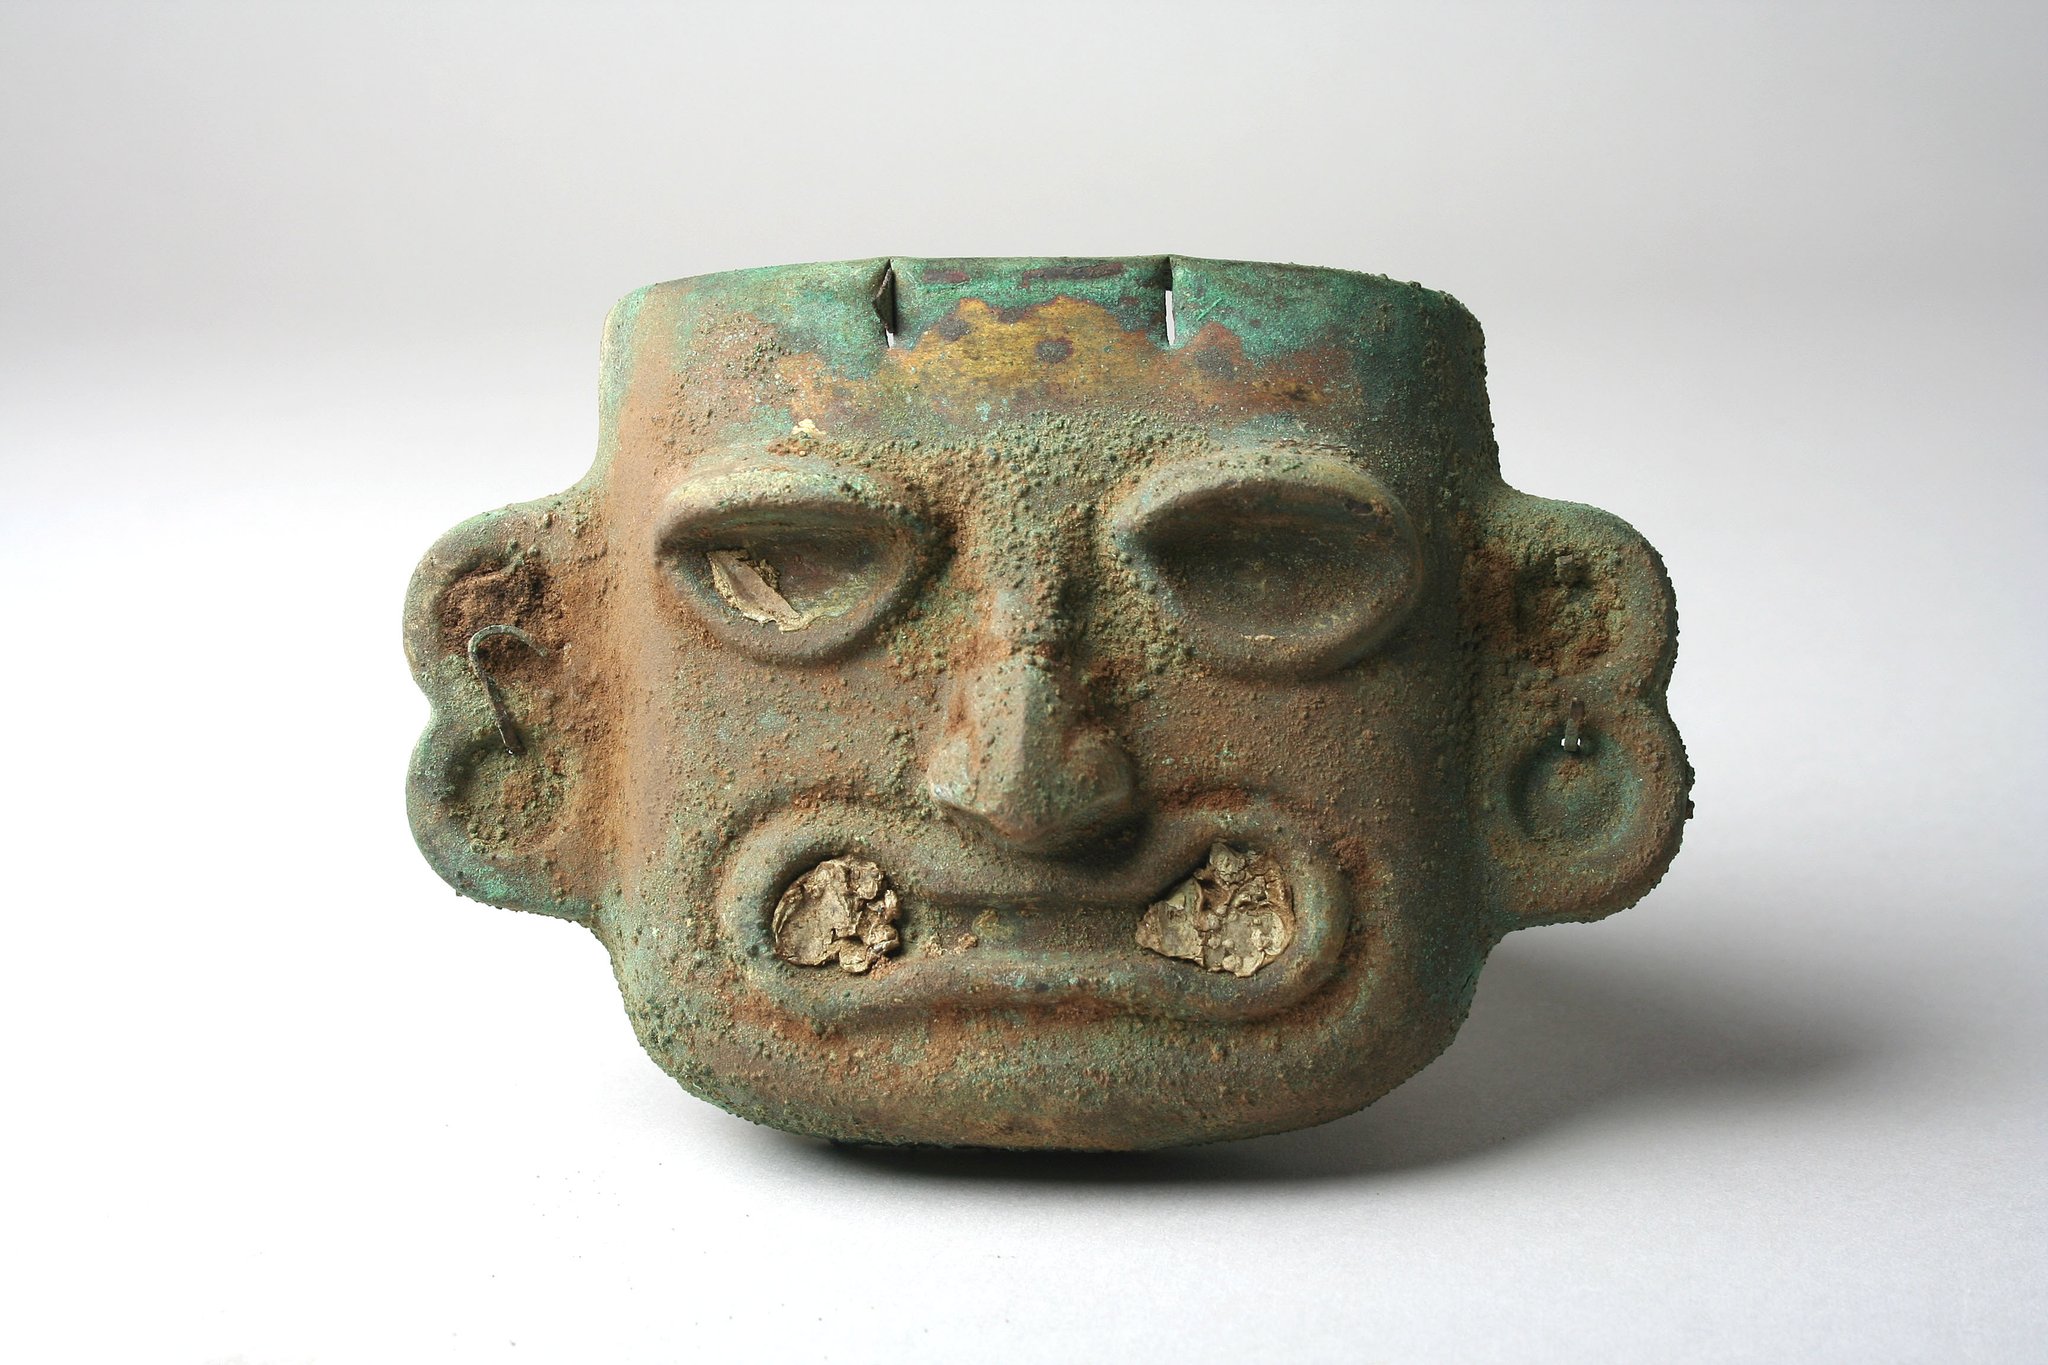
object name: ornament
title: Face Mask Ornament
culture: moche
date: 501-700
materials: gilt copper, shell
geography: peru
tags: faces